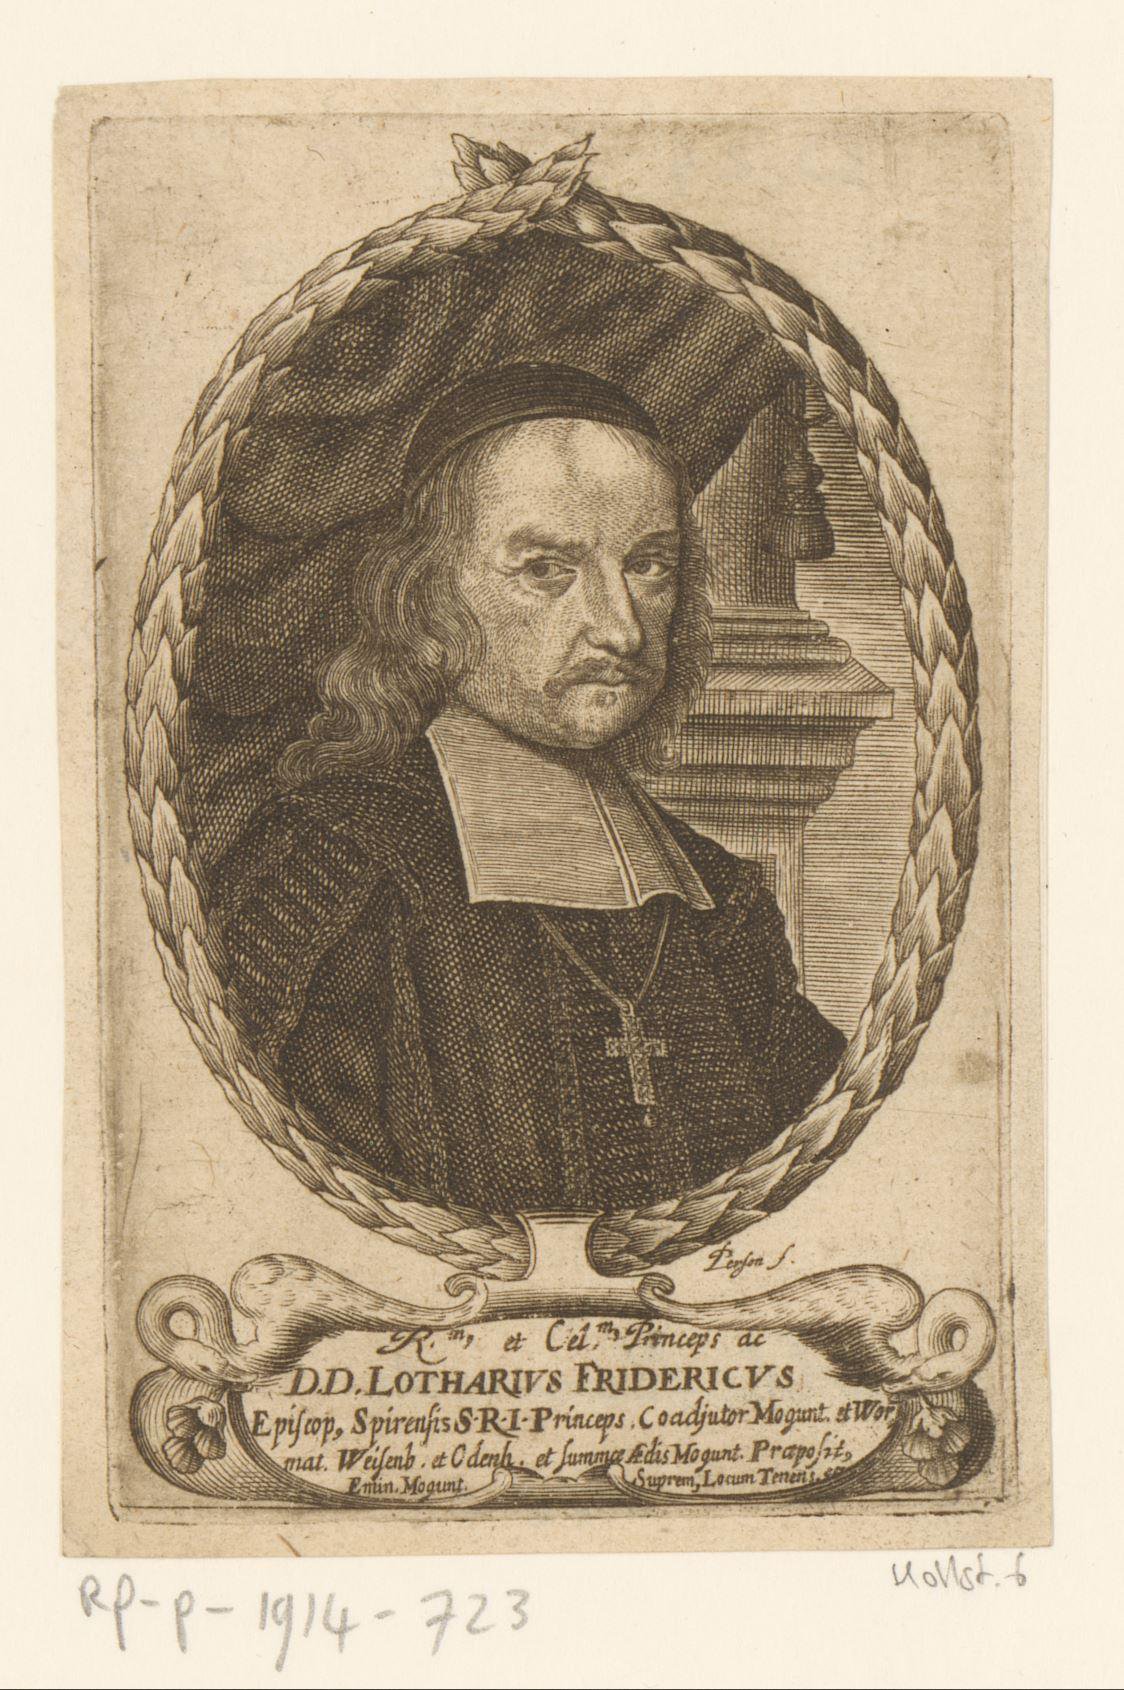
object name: print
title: Portret van Lothar Friedrich Metternich-Burscheid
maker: nikolaus person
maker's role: print maker, publisher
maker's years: 1668-1710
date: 1650-1710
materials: paper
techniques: engraving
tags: historical persons, crucifix ~ personal devotion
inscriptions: collector's mark: Lugt 2228